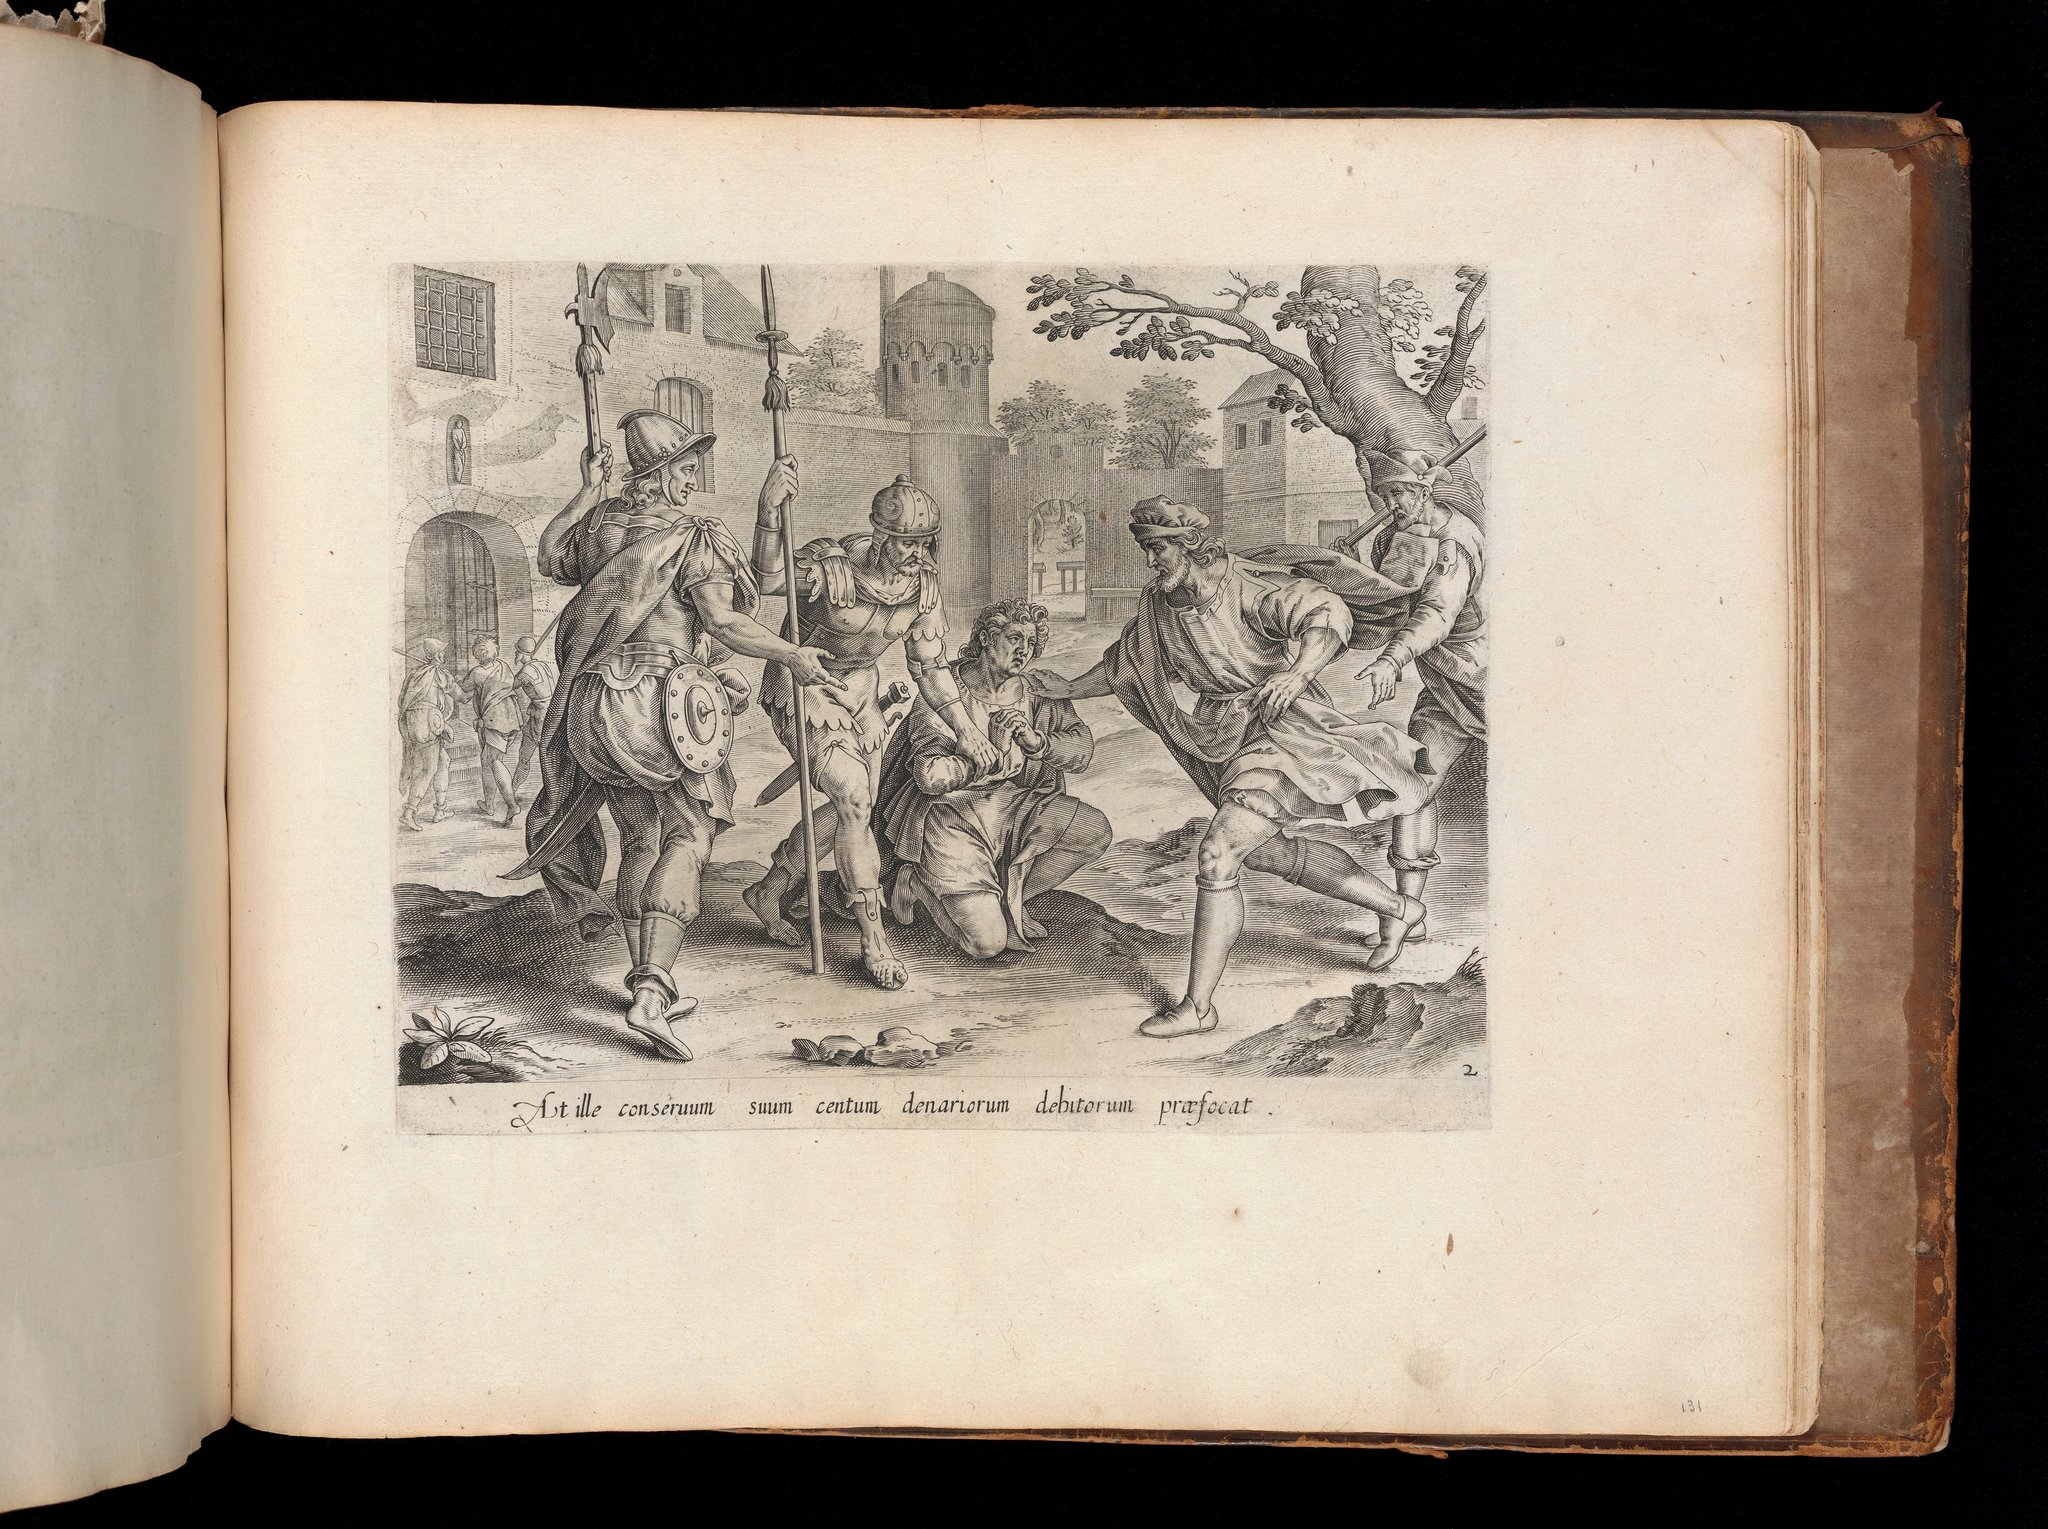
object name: book print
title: The Servant Sending his Fellow Servant to Prison, from The Parable of the Unmerciful Servant, bound in "Thesaurus Sacrarum historiarum Veteris et Novi Testamenti"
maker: anonymous, netherlandish, 16th century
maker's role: engraver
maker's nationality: netherlandish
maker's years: 1500-1600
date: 1585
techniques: engraving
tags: prisons,soldiers,men